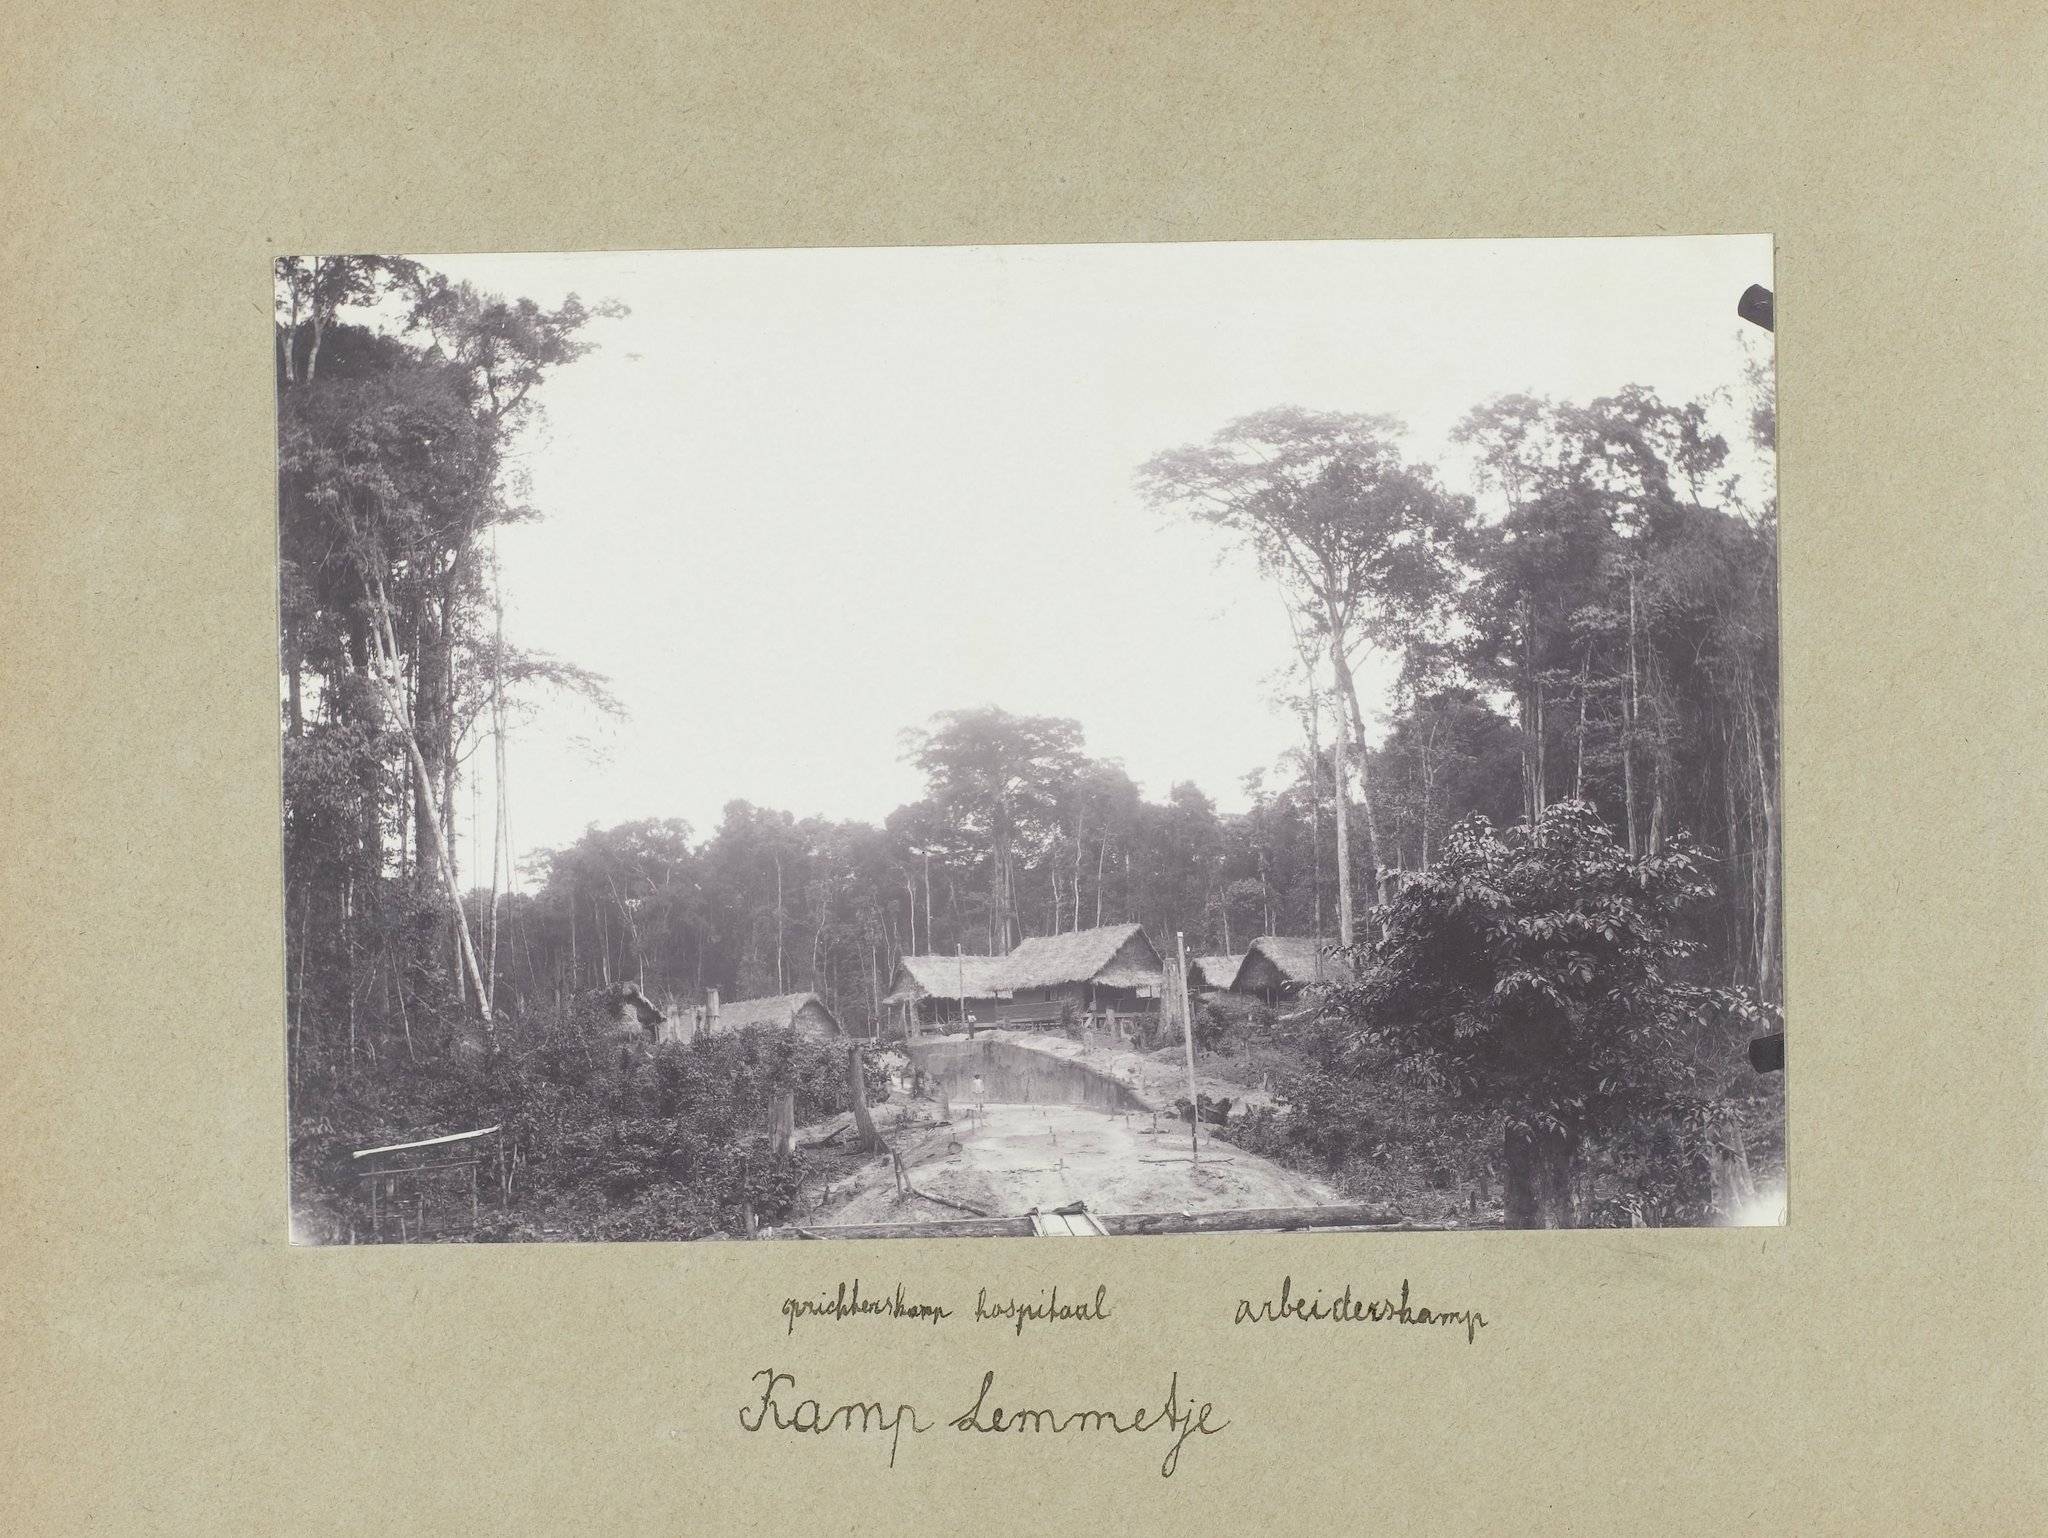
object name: photograph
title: Kamp Lemmetje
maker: jacob evert wesenhagen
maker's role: amateurfotograaf, arts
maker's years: 1862-1924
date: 1905-1910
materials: photographic support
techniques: photography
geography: suriname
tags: jacob evert wesenhagen, railway, tramway; rack railway, suriname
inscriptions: inscription: ‘opzichterskamp hospitaal arbeiderskamp / Kamp Lemmetje’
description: Het tracé voor de nieuwe spoorbaan bij kamp Lemmetje. In het kamp de opzichterswoning, hospitaal en arbeiderskamp. Foto in het fotoalbum over de aanleg van de Lawaspoorweg in Suriname in de jaren 1903-1912. Onderdeel van een groep objecten afkomstig van de familie Wesenhagen in Suriname.